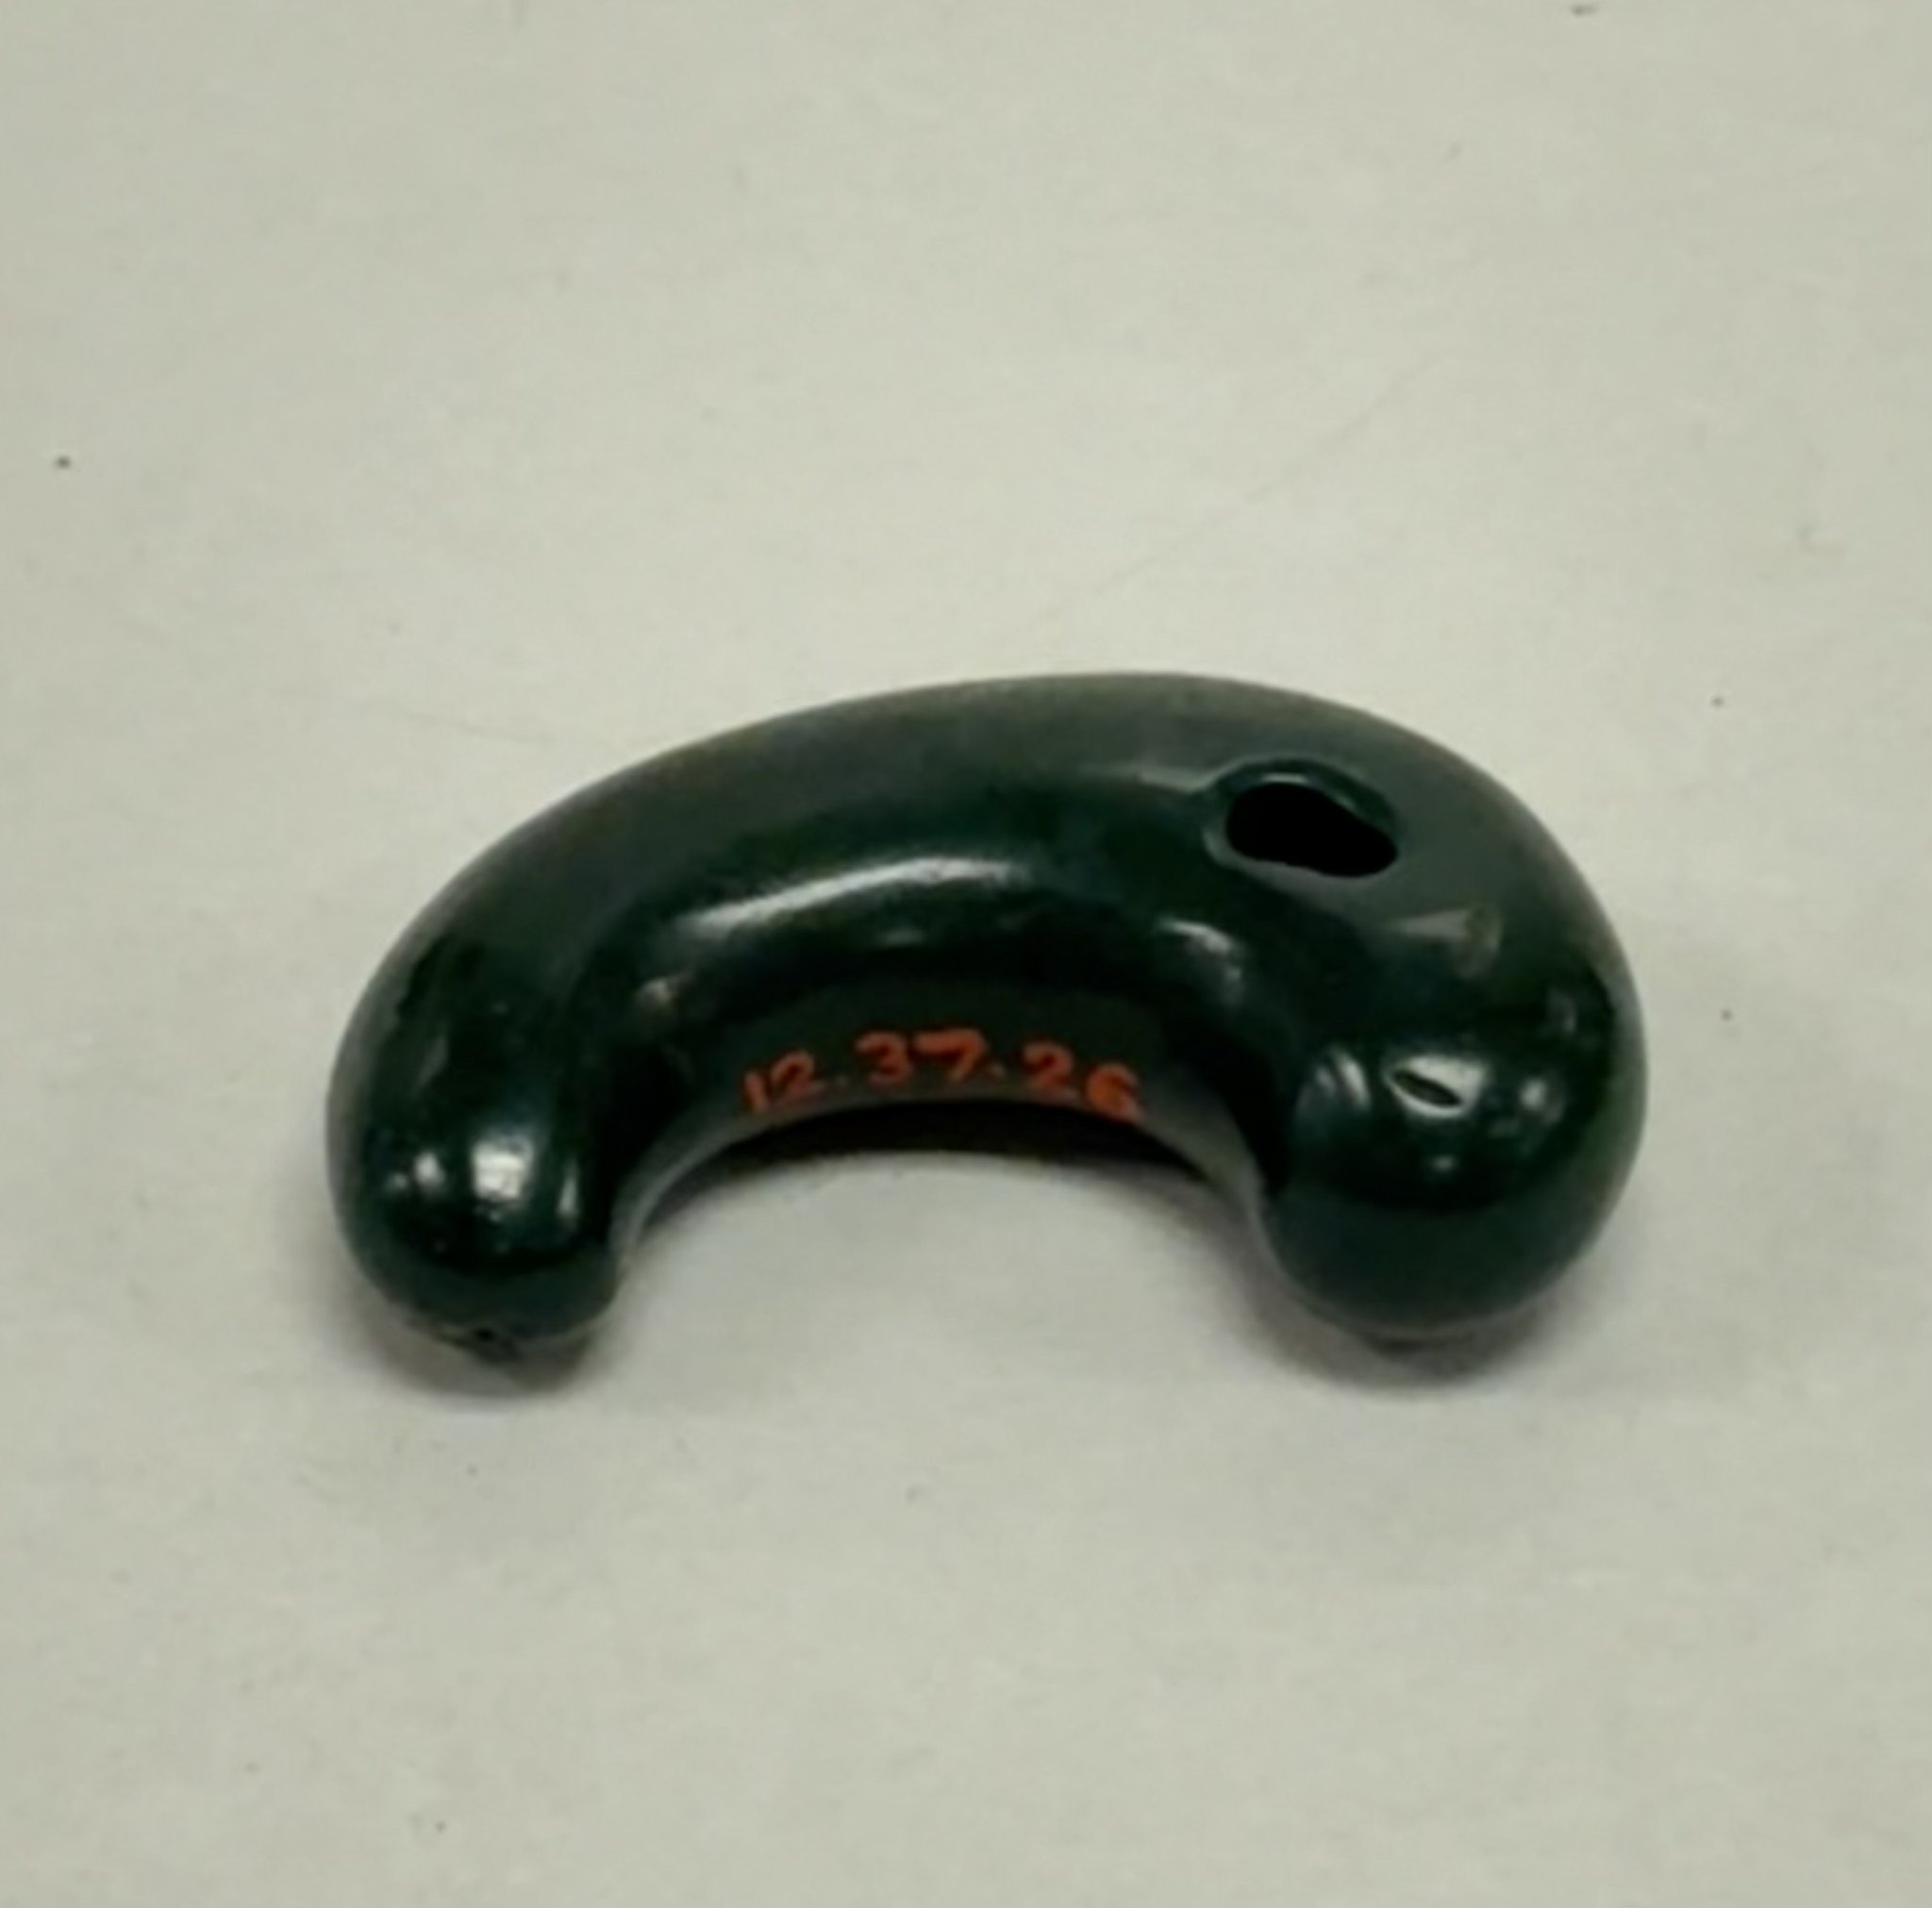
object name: jewel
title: Tiger Claw Jewel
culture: japanese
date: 601-700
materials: stone, jade, jasper